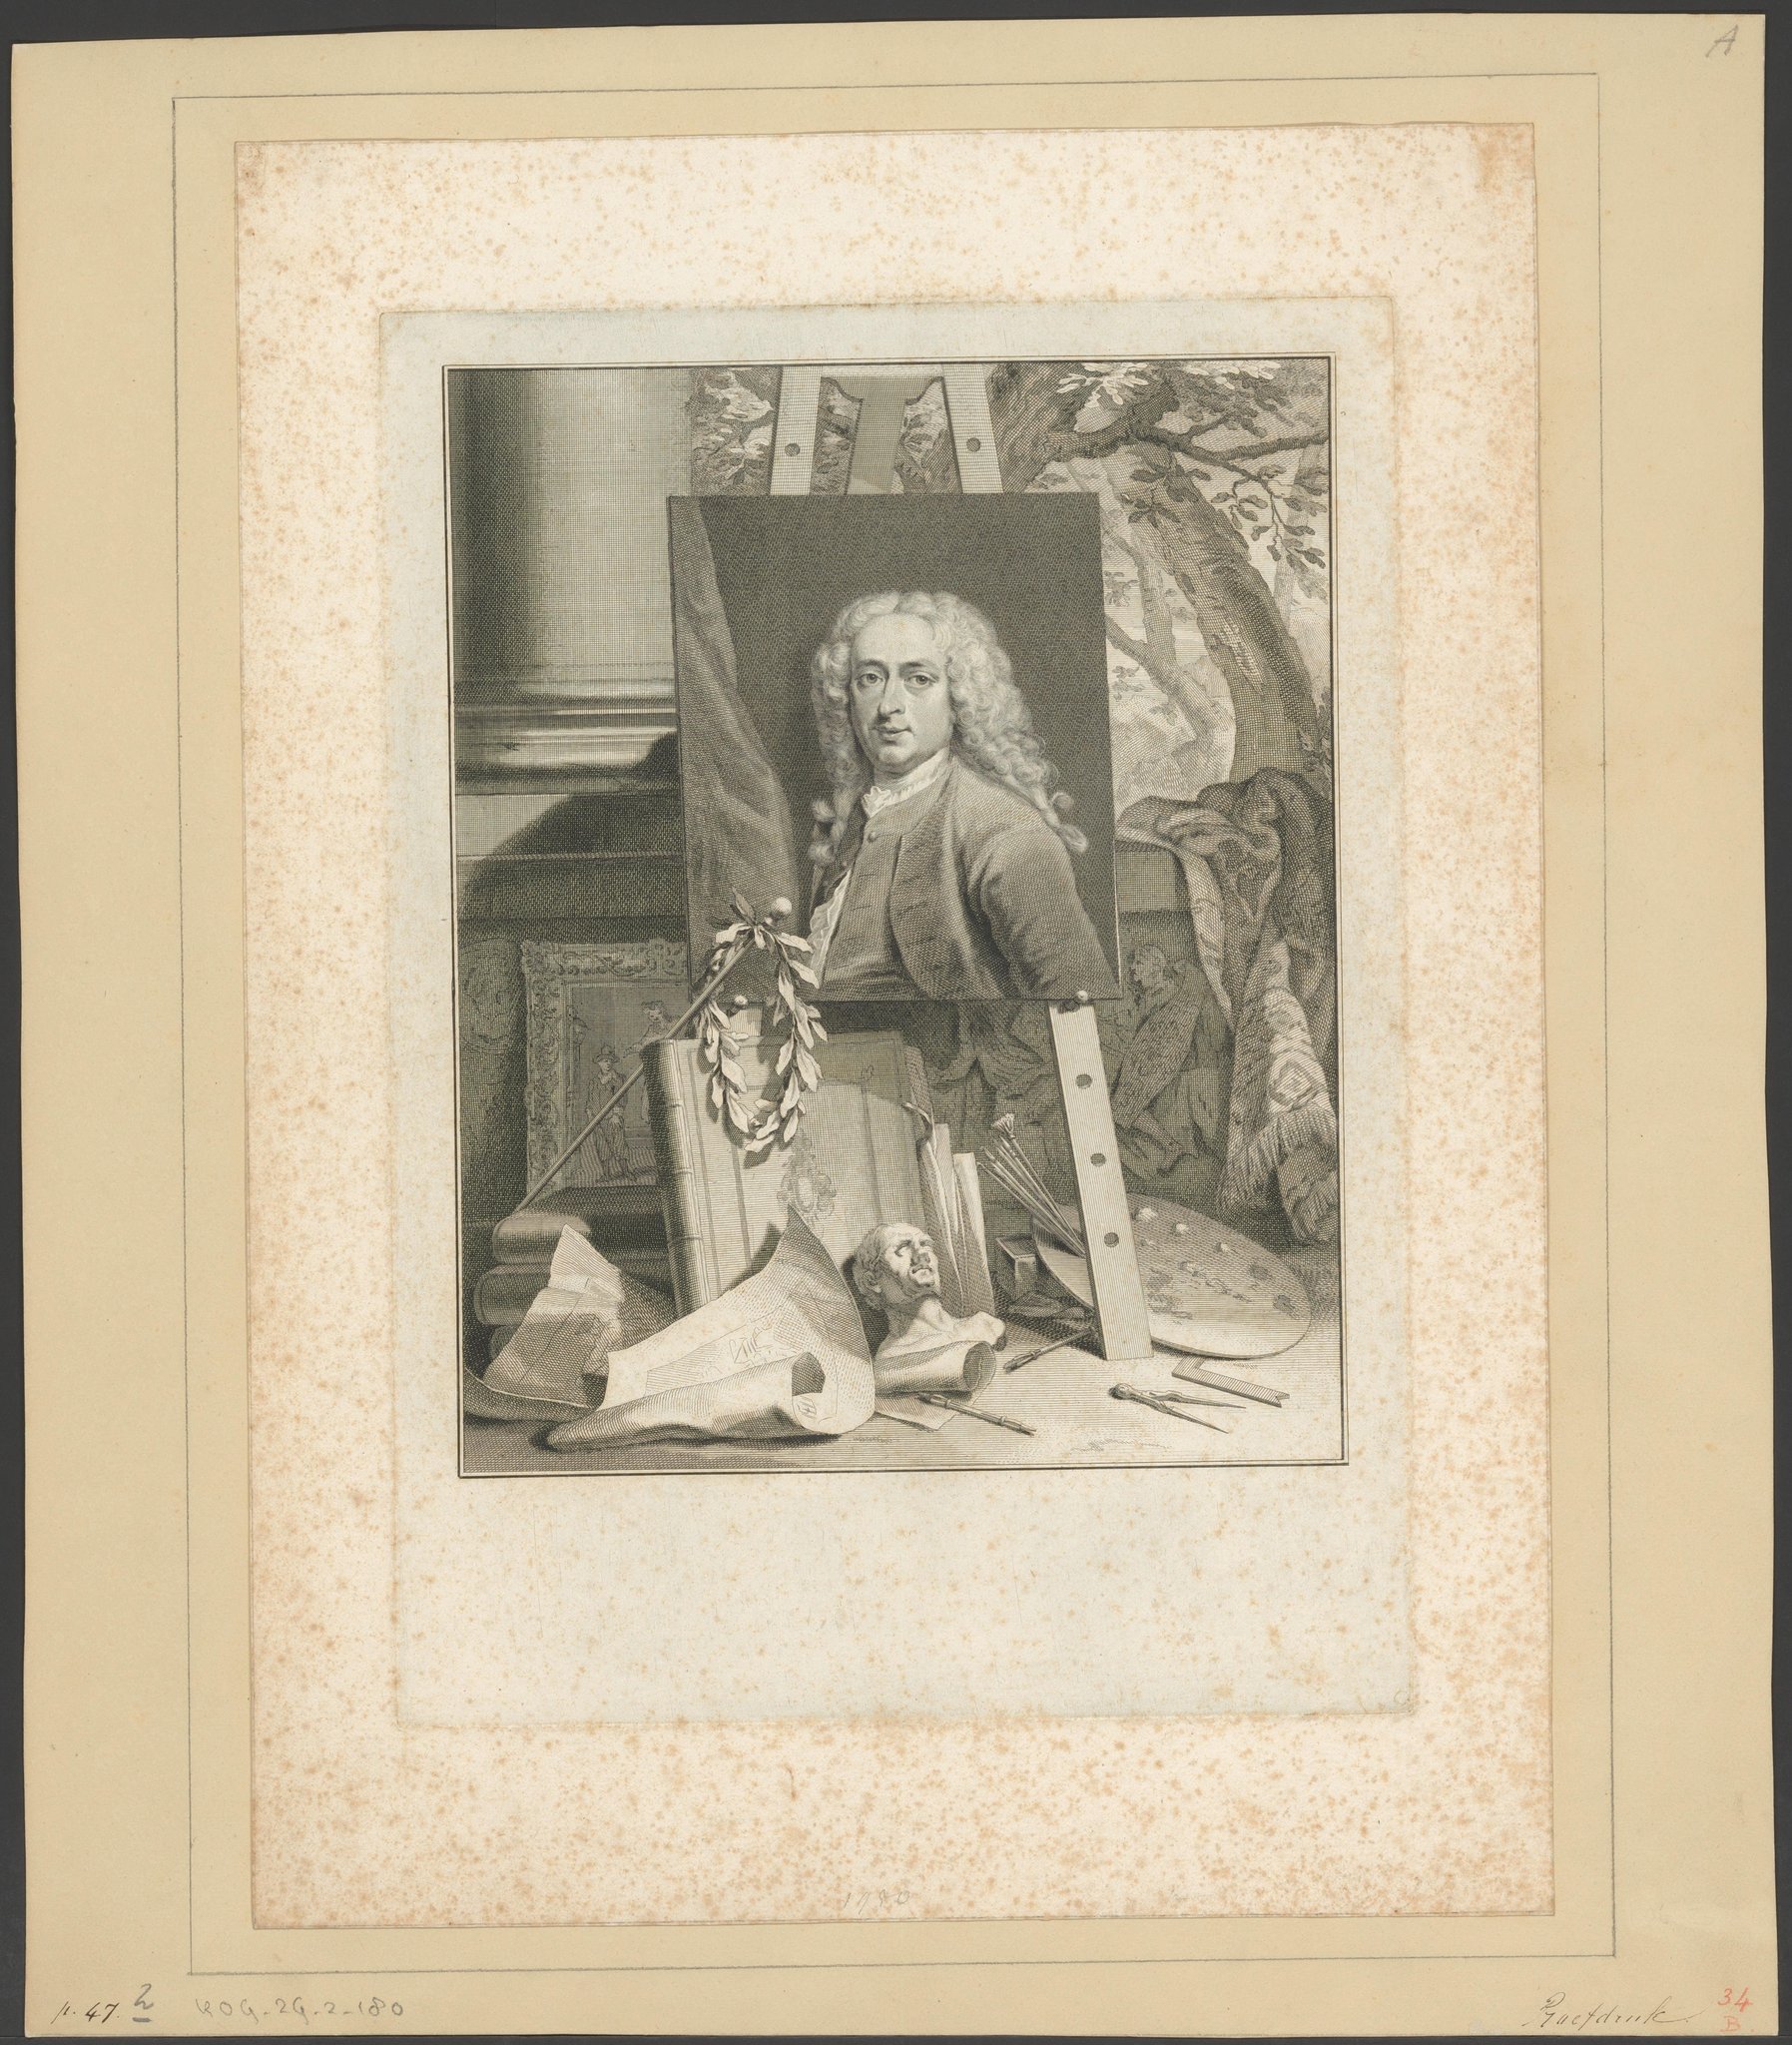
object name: print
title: Portret van Cornelis Troost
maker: jacob houbraken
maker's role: draughtsman, print maker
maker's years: 1698-1780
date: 1760-1780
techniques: printmaking, engraving, etching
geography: amsterdam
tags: painter, cornelis troost, historical persons, portrait, self-portrait of painter, portrait, self-portrait of artist, palette, wig, brushes ~ implements of painter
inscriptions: collector's mark: Lugt 2488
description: Portret van de schilder Cornelis Troost. Het schilderij met zijn portret staat op een schildersezel op een bordes en is omringd door de attributen van de schilder- en graveerkunst. Onder de ezel liggen palet en penselen, een gebeeldhouwde kop, tekenstiften, boeken en tekeningen. Links staat de schildersstok, waaraan een lauwerkrans hangt. Daarachter een schilderij in lijst. In de achtergrond een doorkijk naar een landschap.